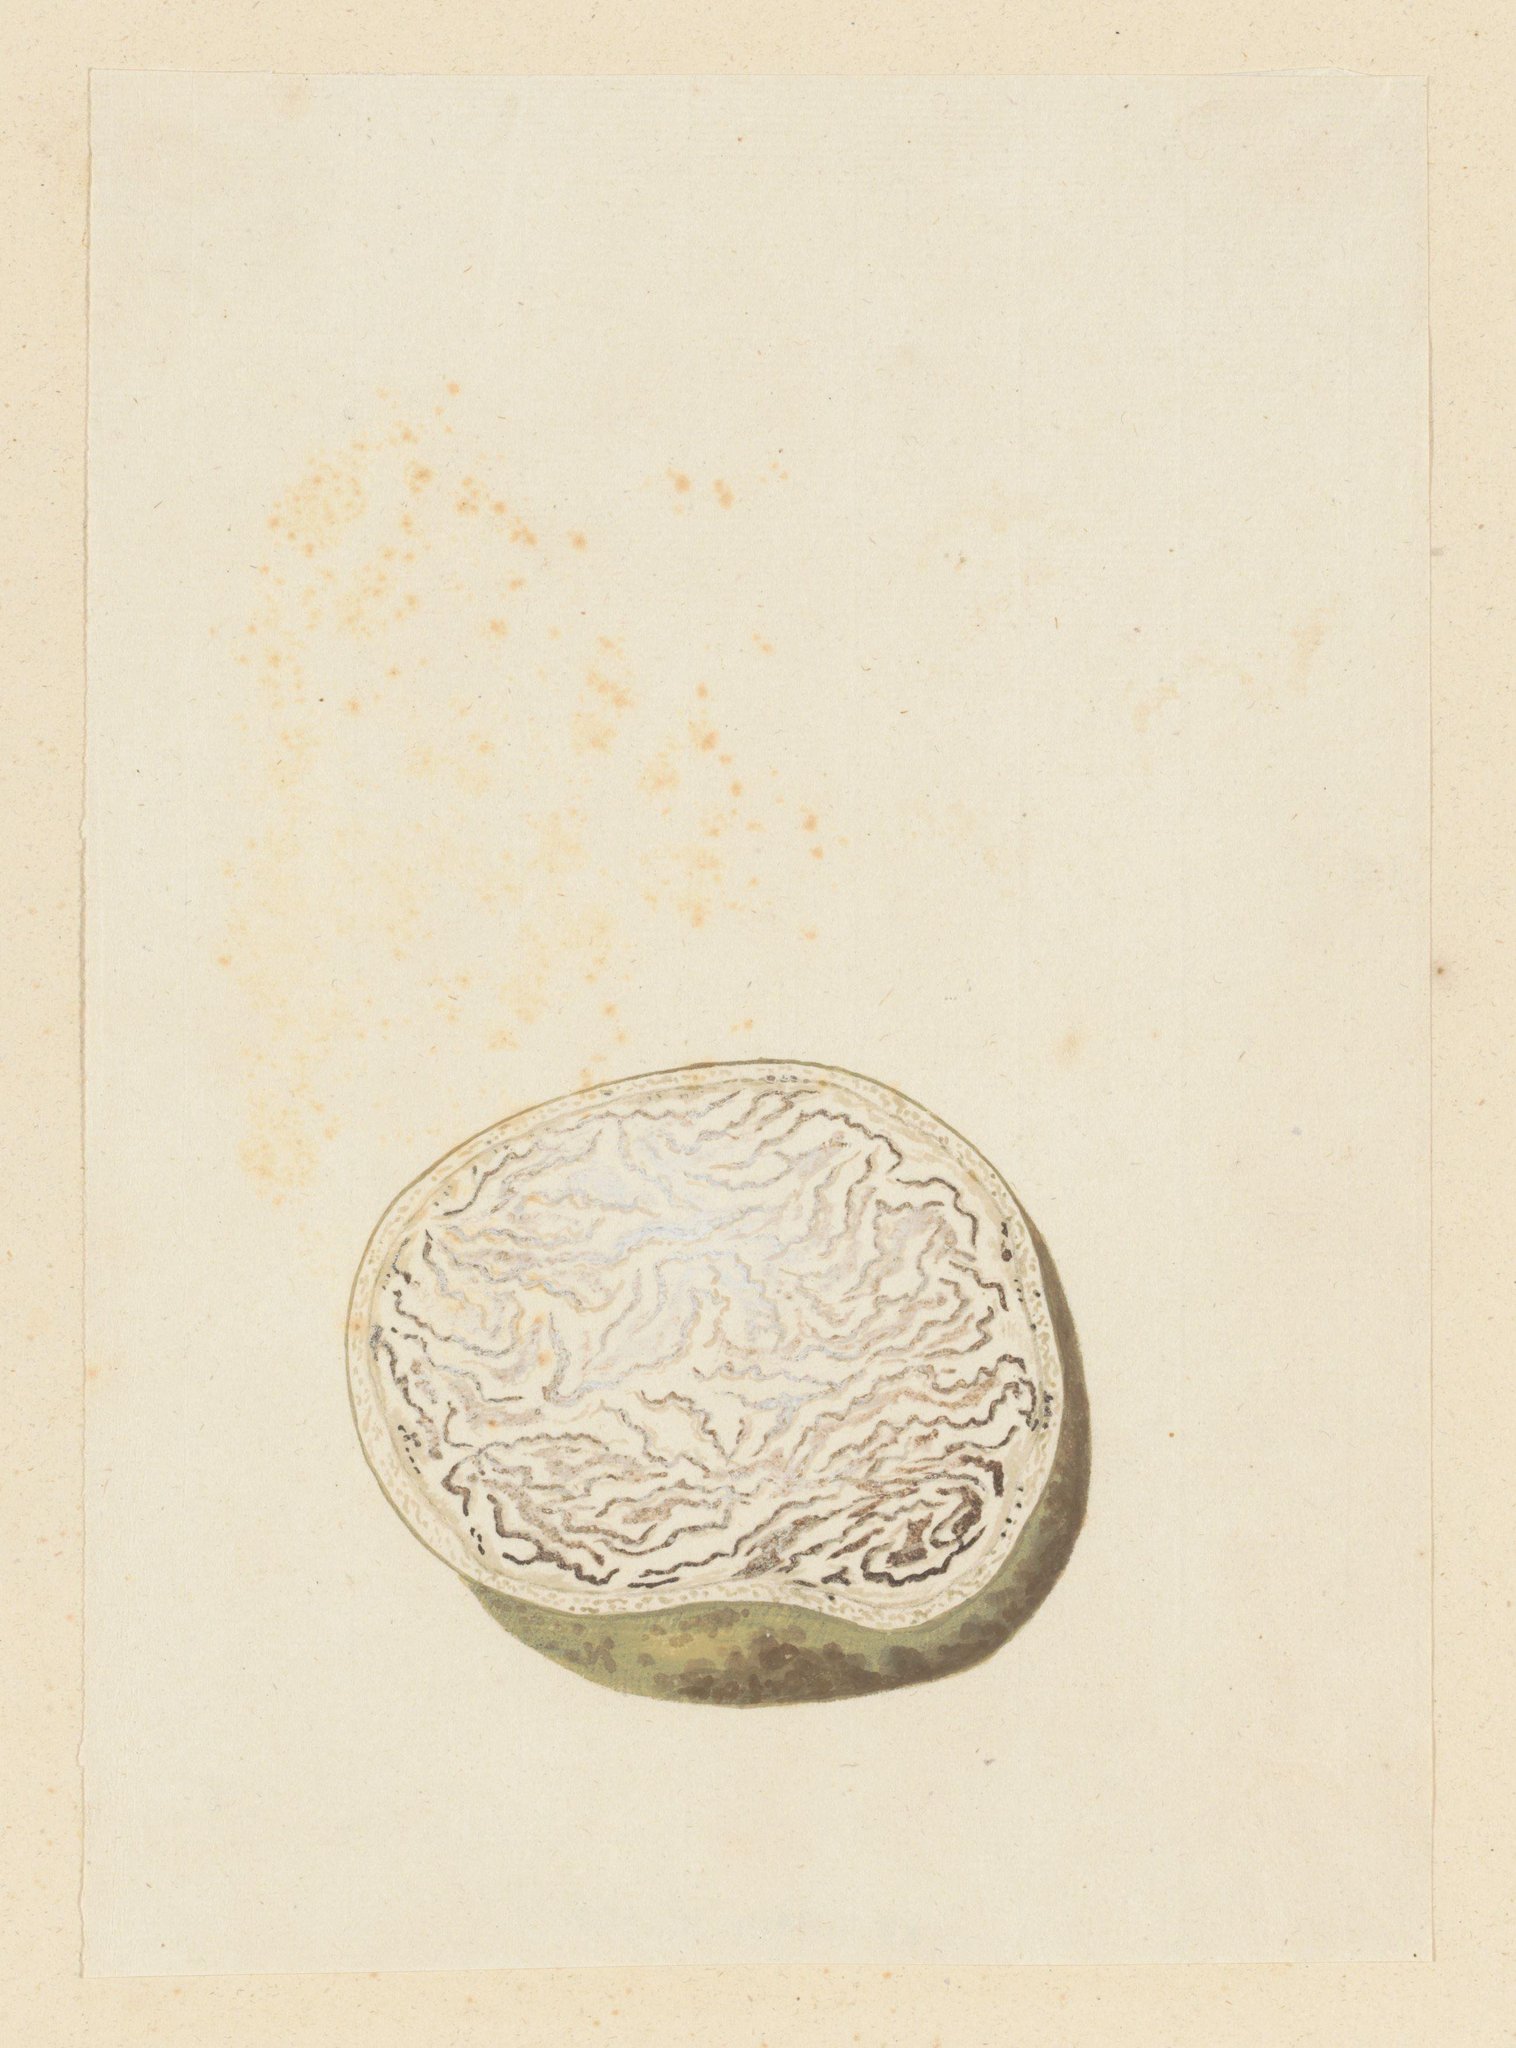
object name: album leaf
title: Hydnora africana Thunb. (Jackal-food plant), cross section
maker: robert jacob gordon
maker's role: draughtsman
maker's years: 1743-1795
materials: chalk, paper, pencil, watercolor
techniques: brush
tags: plants; vegetation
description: De tekening is gemaakt voor of tijdens een van Gordon's vier expedities door de Kaapprovincie, van oktober 1777 tot maart 1786. Sommige (soort)namen kunnen zijn gewijzigd, gezien reorganisatie in plantentaxonomie gedurende de afgelopen jaren.